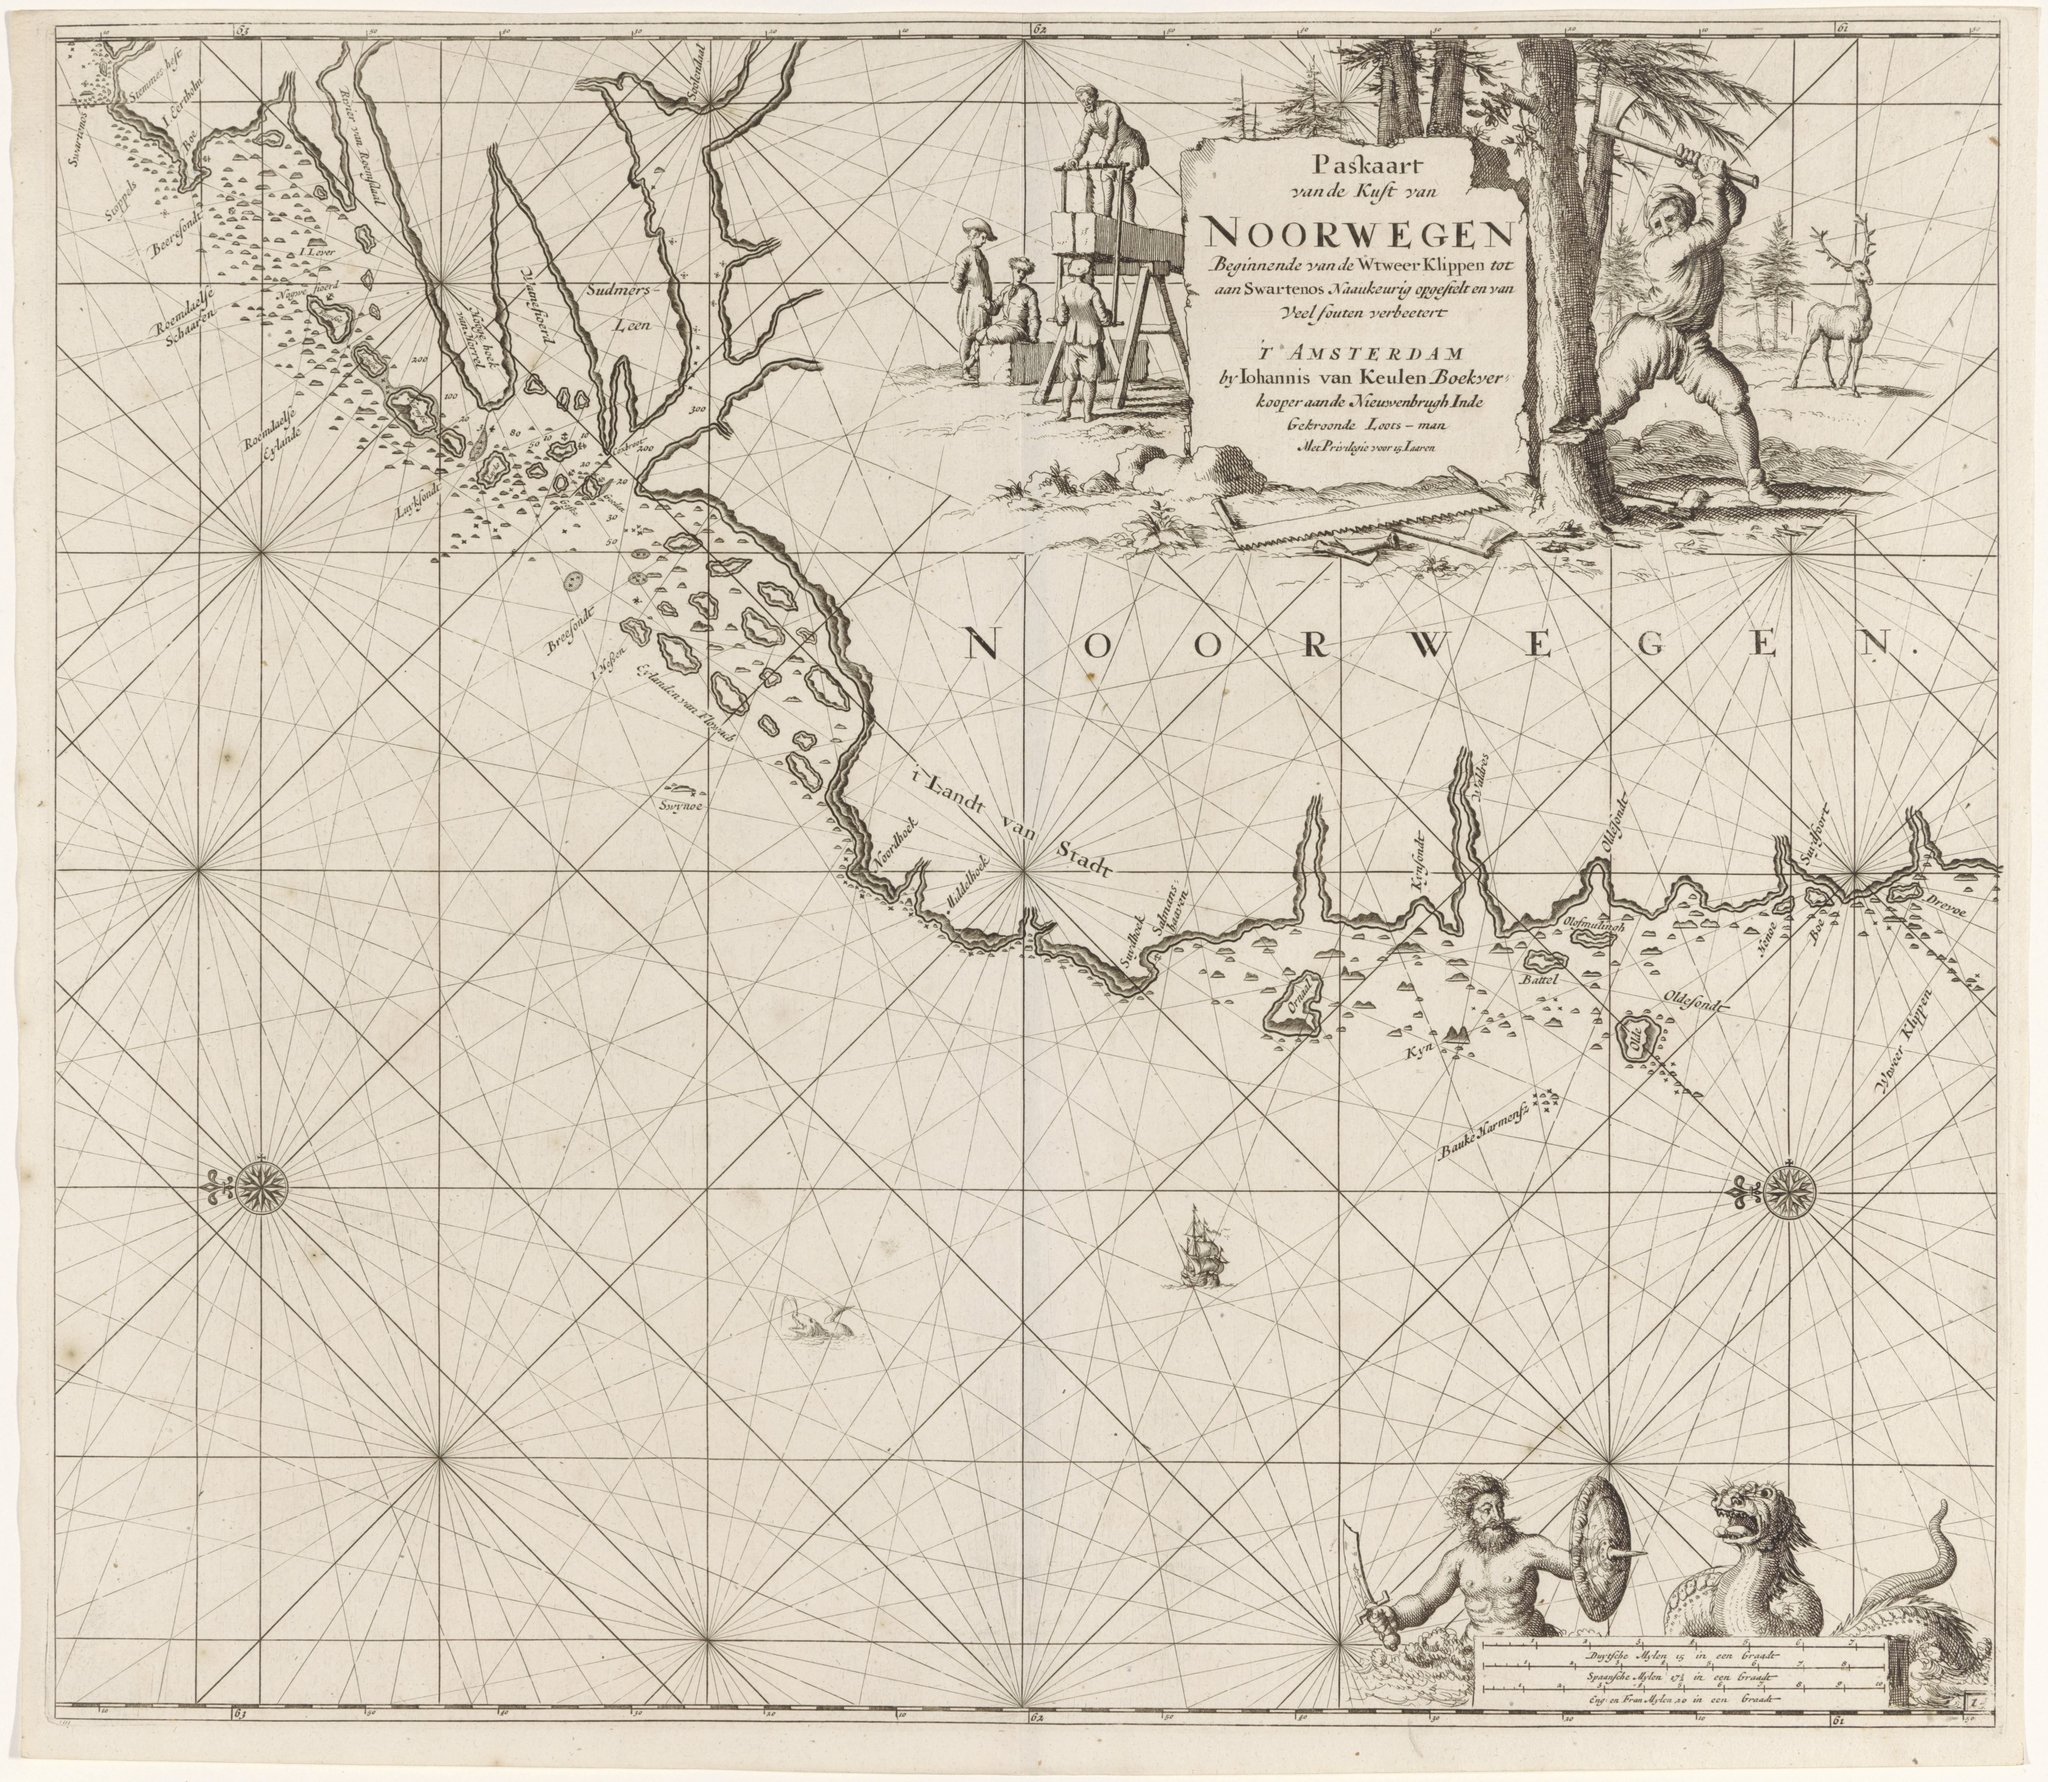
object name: print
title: Paskaart van de Kust van Noorwegen Beginnende van de Wtweer Klippen tot aan Swartenos Naaukeurig opgestelt en van Veel fouten verbeetert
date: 1681-1799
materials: paper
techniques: engraving, etching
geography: amsterdam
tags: hoofed animals: deer, woodcutting, woodcutter ~ forestry, monsters of the sea, norway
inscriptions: collector's mark: Lugt 2228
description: Paskaart van een gedeelte van de westkust van Noorwegen, met twee kompasrozen, het Noorden ligt links. Rechtsboven een cartouche met de titel en het adres van de uitgever, waarnaast een houthakker bezig is om een boom om te hakken, op de achtergrond een hert. Links van de cartouche zagen drie mannen dikke planken hout. Rechtsonder een gewapende Triton in strijd met een zeeslang, waaronder de schaalverdeling, weergegeven in Duitse, Spaanse en Engelse of Franse mijlenschaal (c. 1:450.000).